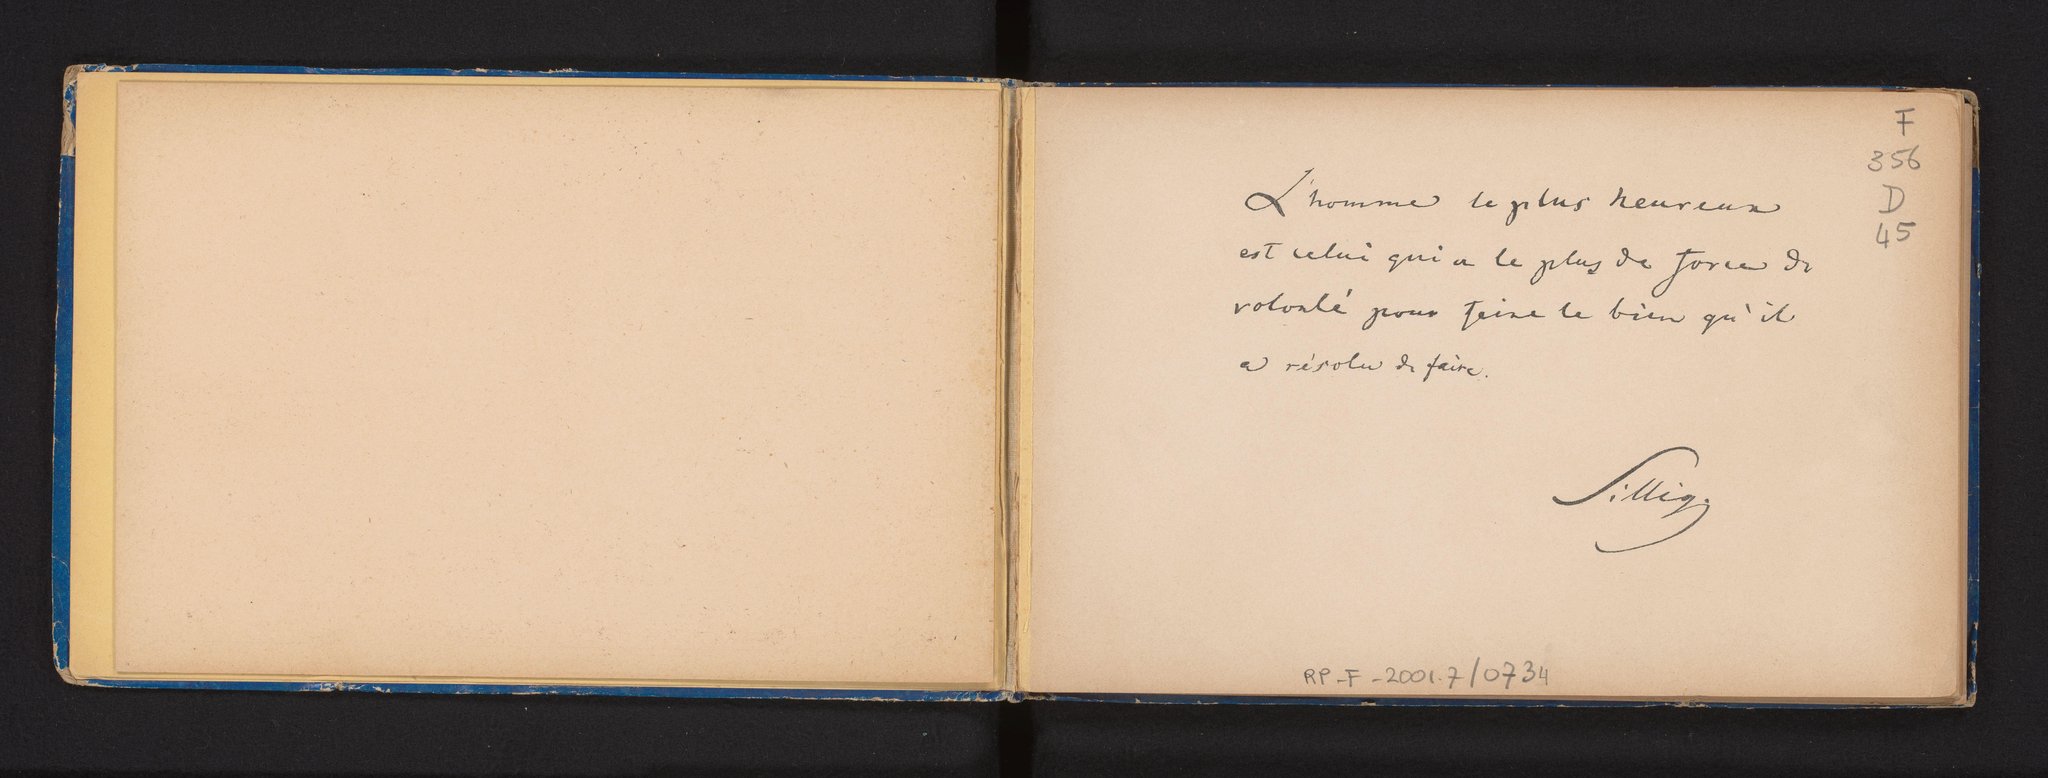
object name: book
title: Bellerive Institution Sillig Vevey Suisse, 1836-1886 souvenir du jubilé 50naire de la fondation de l'Etablissement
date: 1886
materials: cardboard, paper, photographic support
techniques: albumen print, lithograph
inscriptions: inscription: ‘L'homme le plus heureux est celui qui a le plus de force de volonté pour [...]eine le bien qu'il a répolu de faire. Sillig.’, inscription: ‘Souvenir of my sojourn at Bellerive. Frank. D. Brannan.’, inscription: ‘Souvenir of my sojourn at Bellerive. 1890-91 Frank. D. Brannan.’